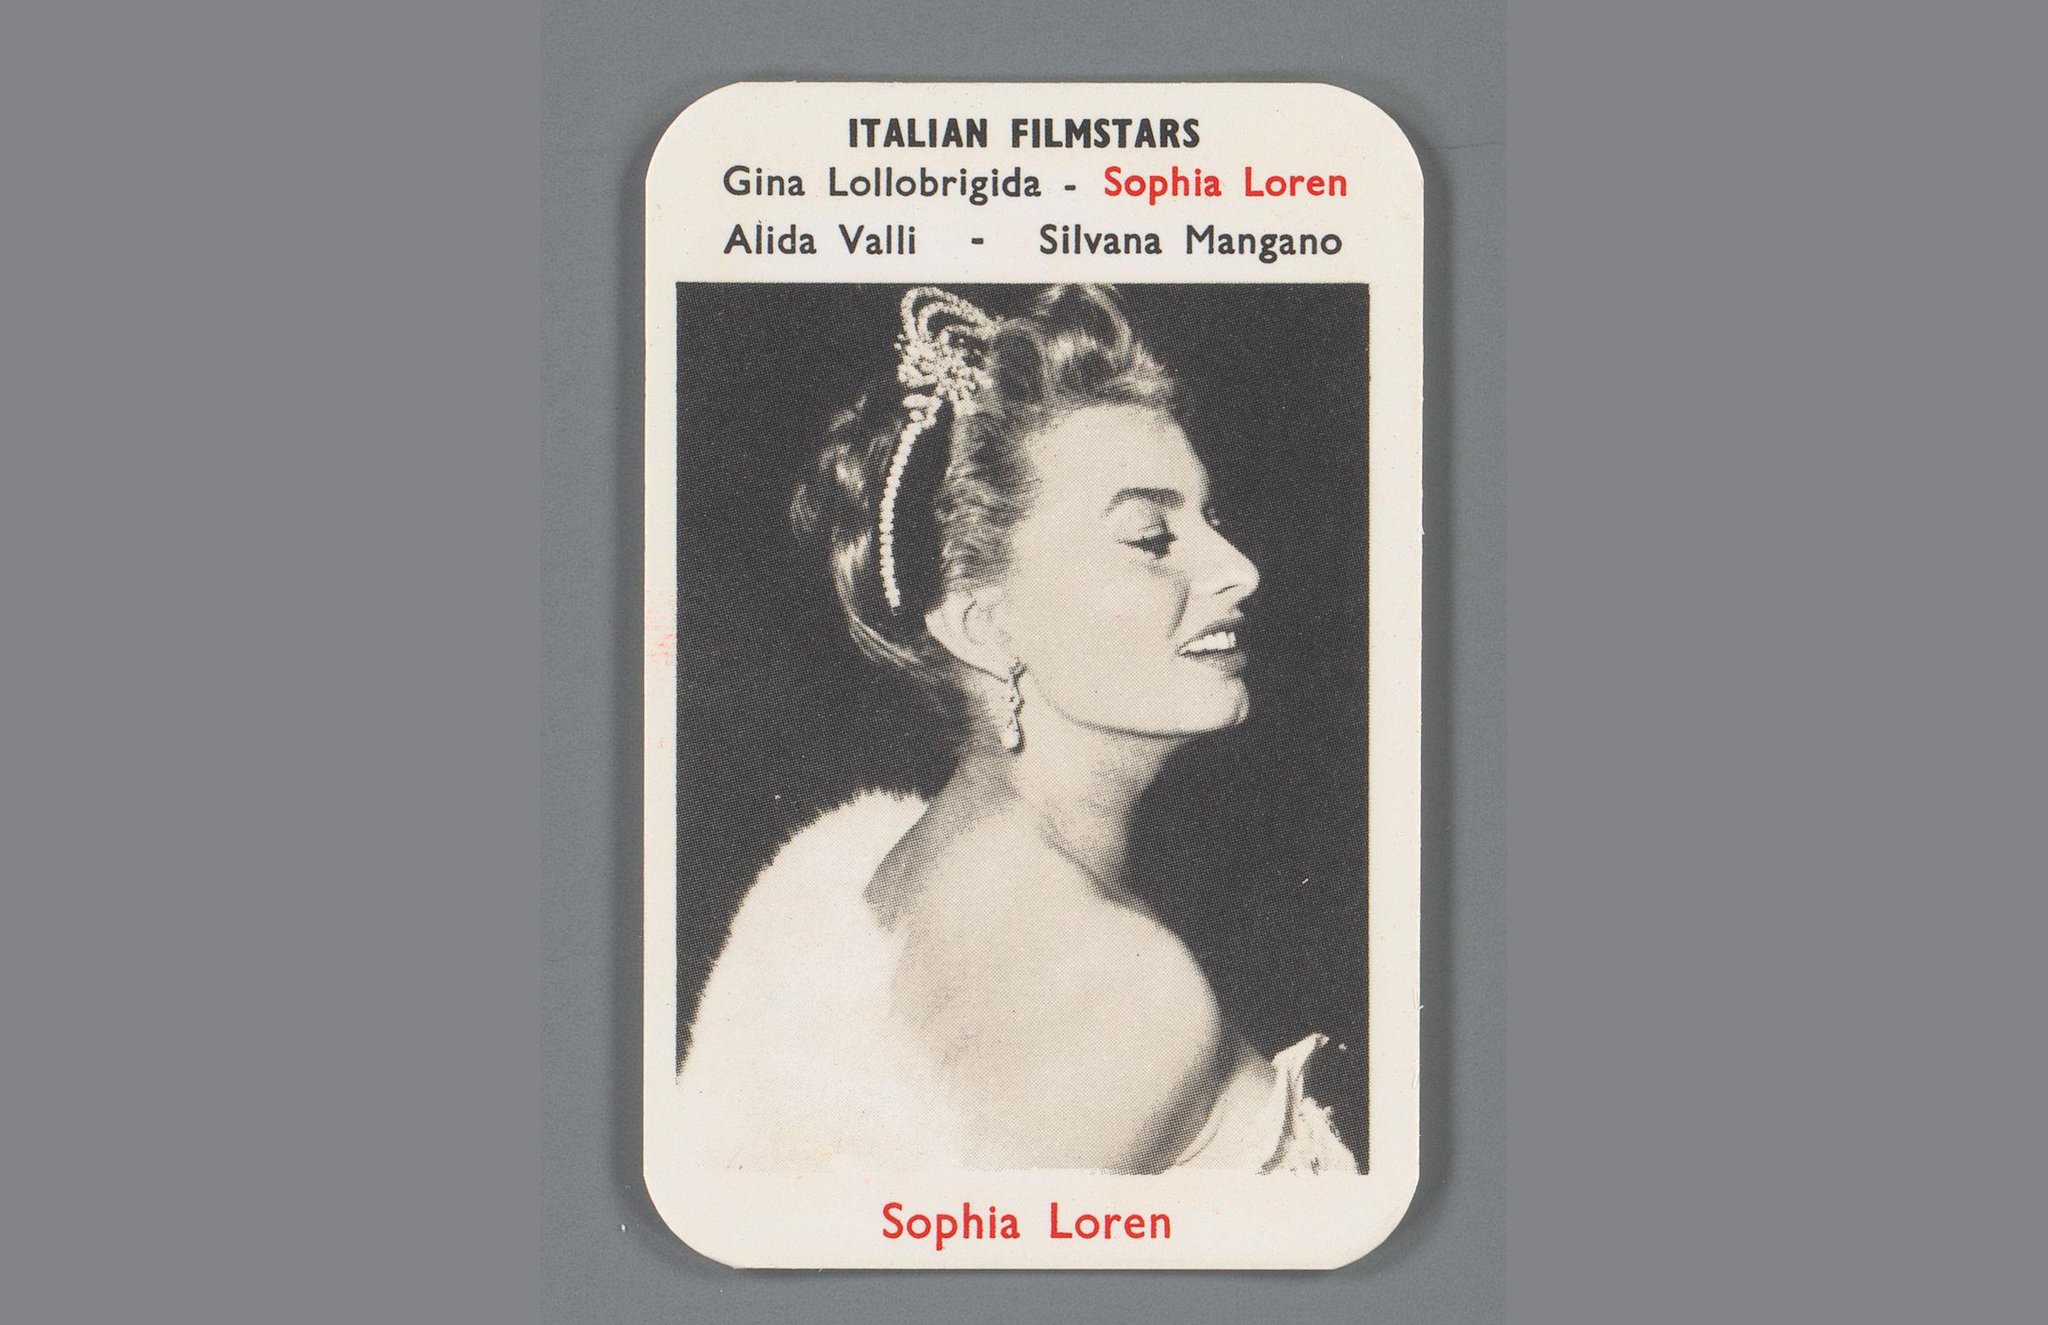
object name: photomechanical print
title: Portret van Sophia Loren; onderdeel van het kwartet Italian Filmstars uit een kwartetspel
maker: Anonymous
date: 1960-1970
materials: paper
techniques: autotype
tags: portrait of actor, actress